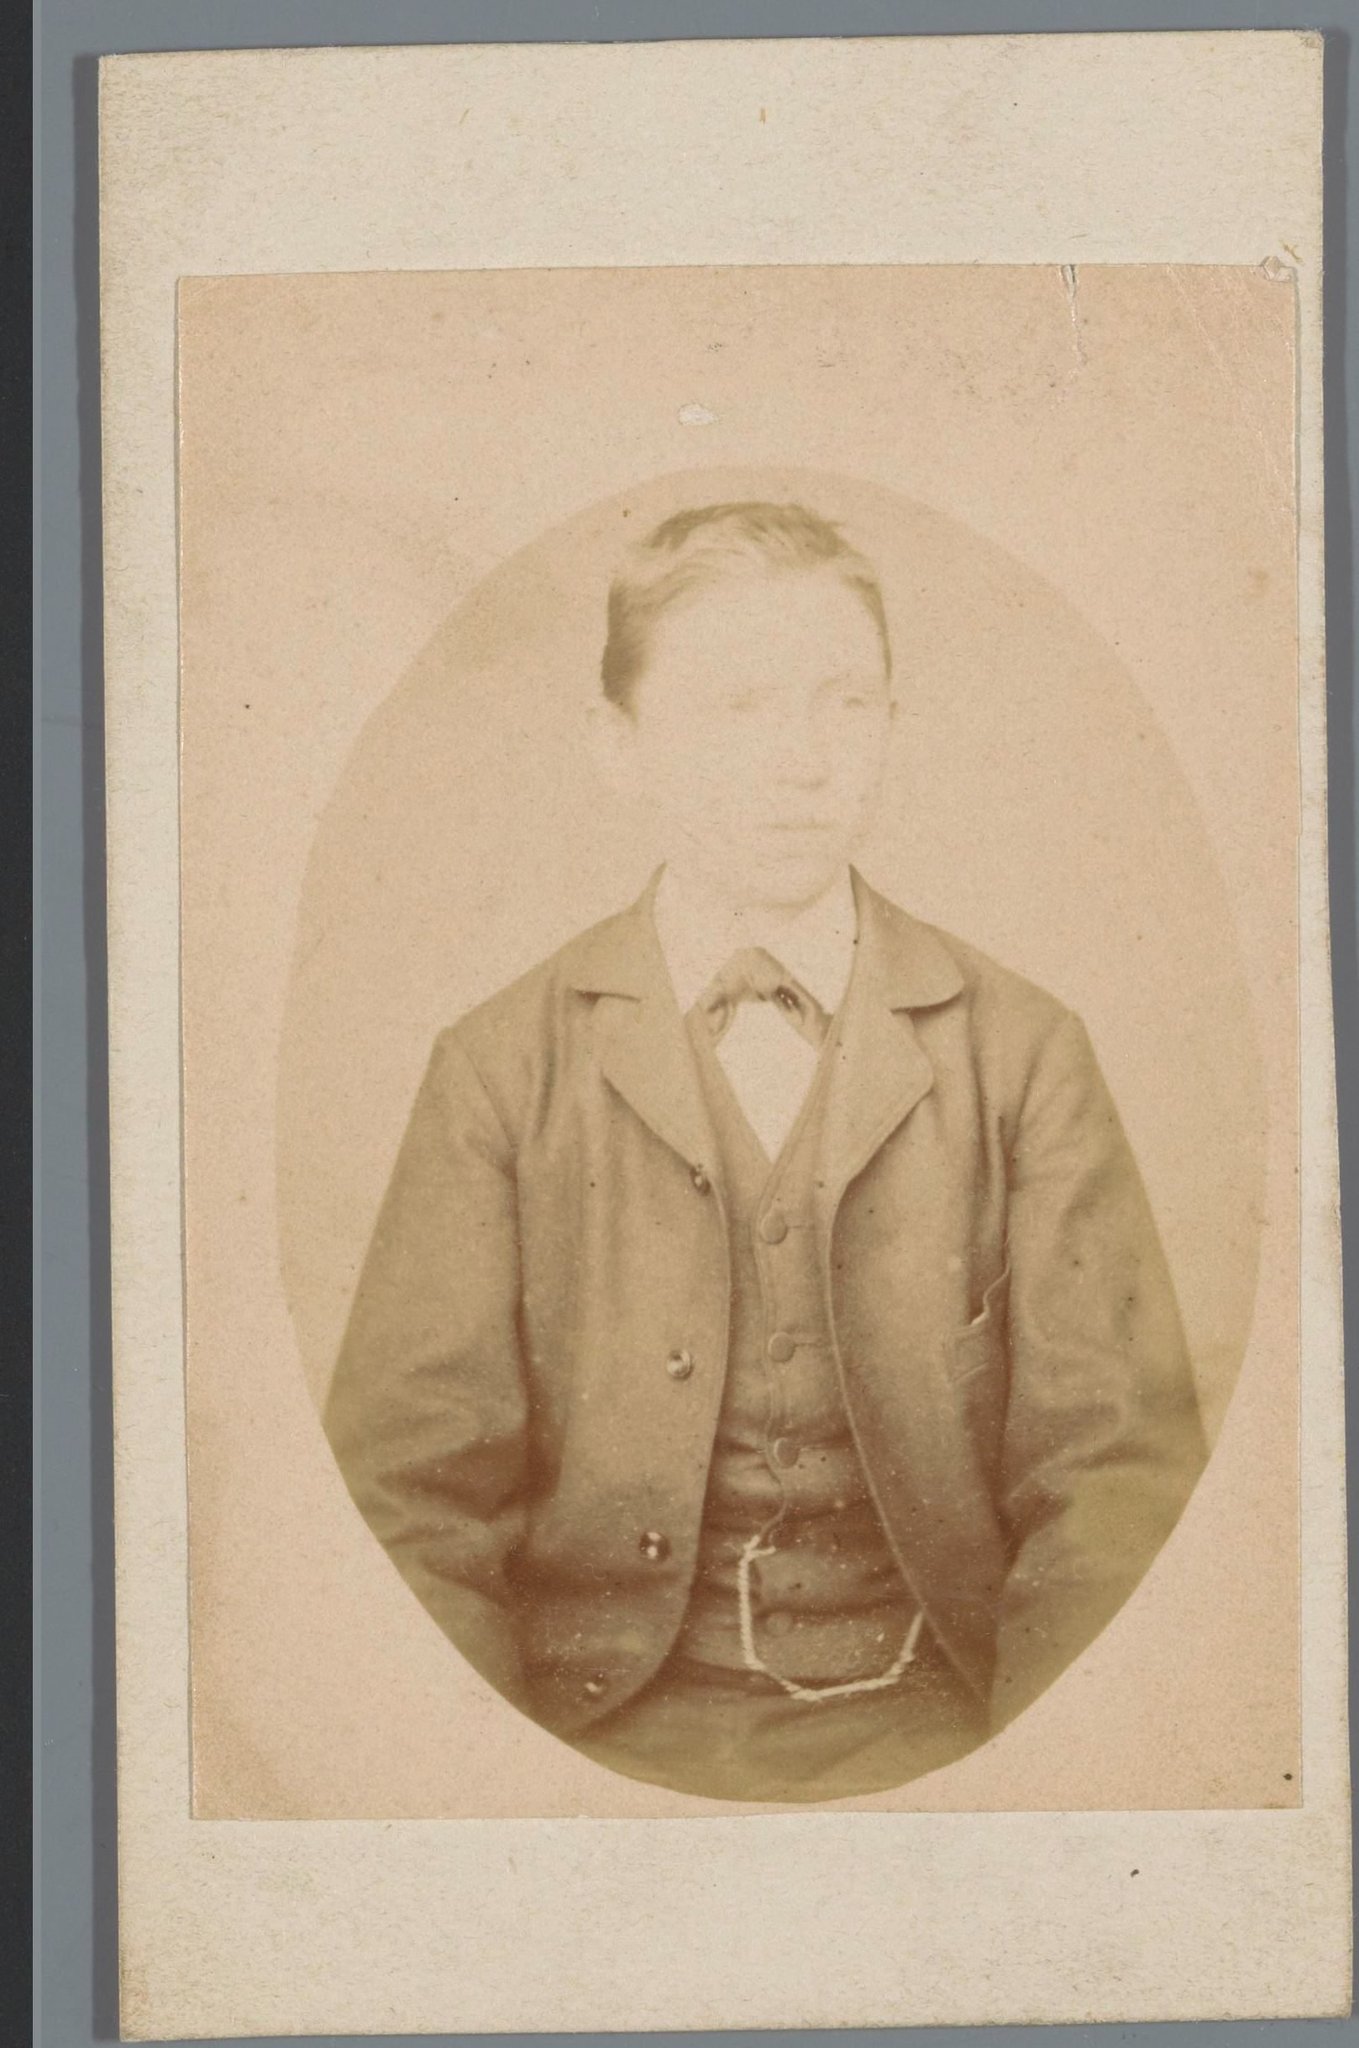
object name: photograph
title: Portret van een onbekende jongen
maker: Anonymous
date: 1855-1885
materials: cardboard, paper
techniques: albumen print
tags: boy (child between toddler and youth), anonymous historical person portrayed